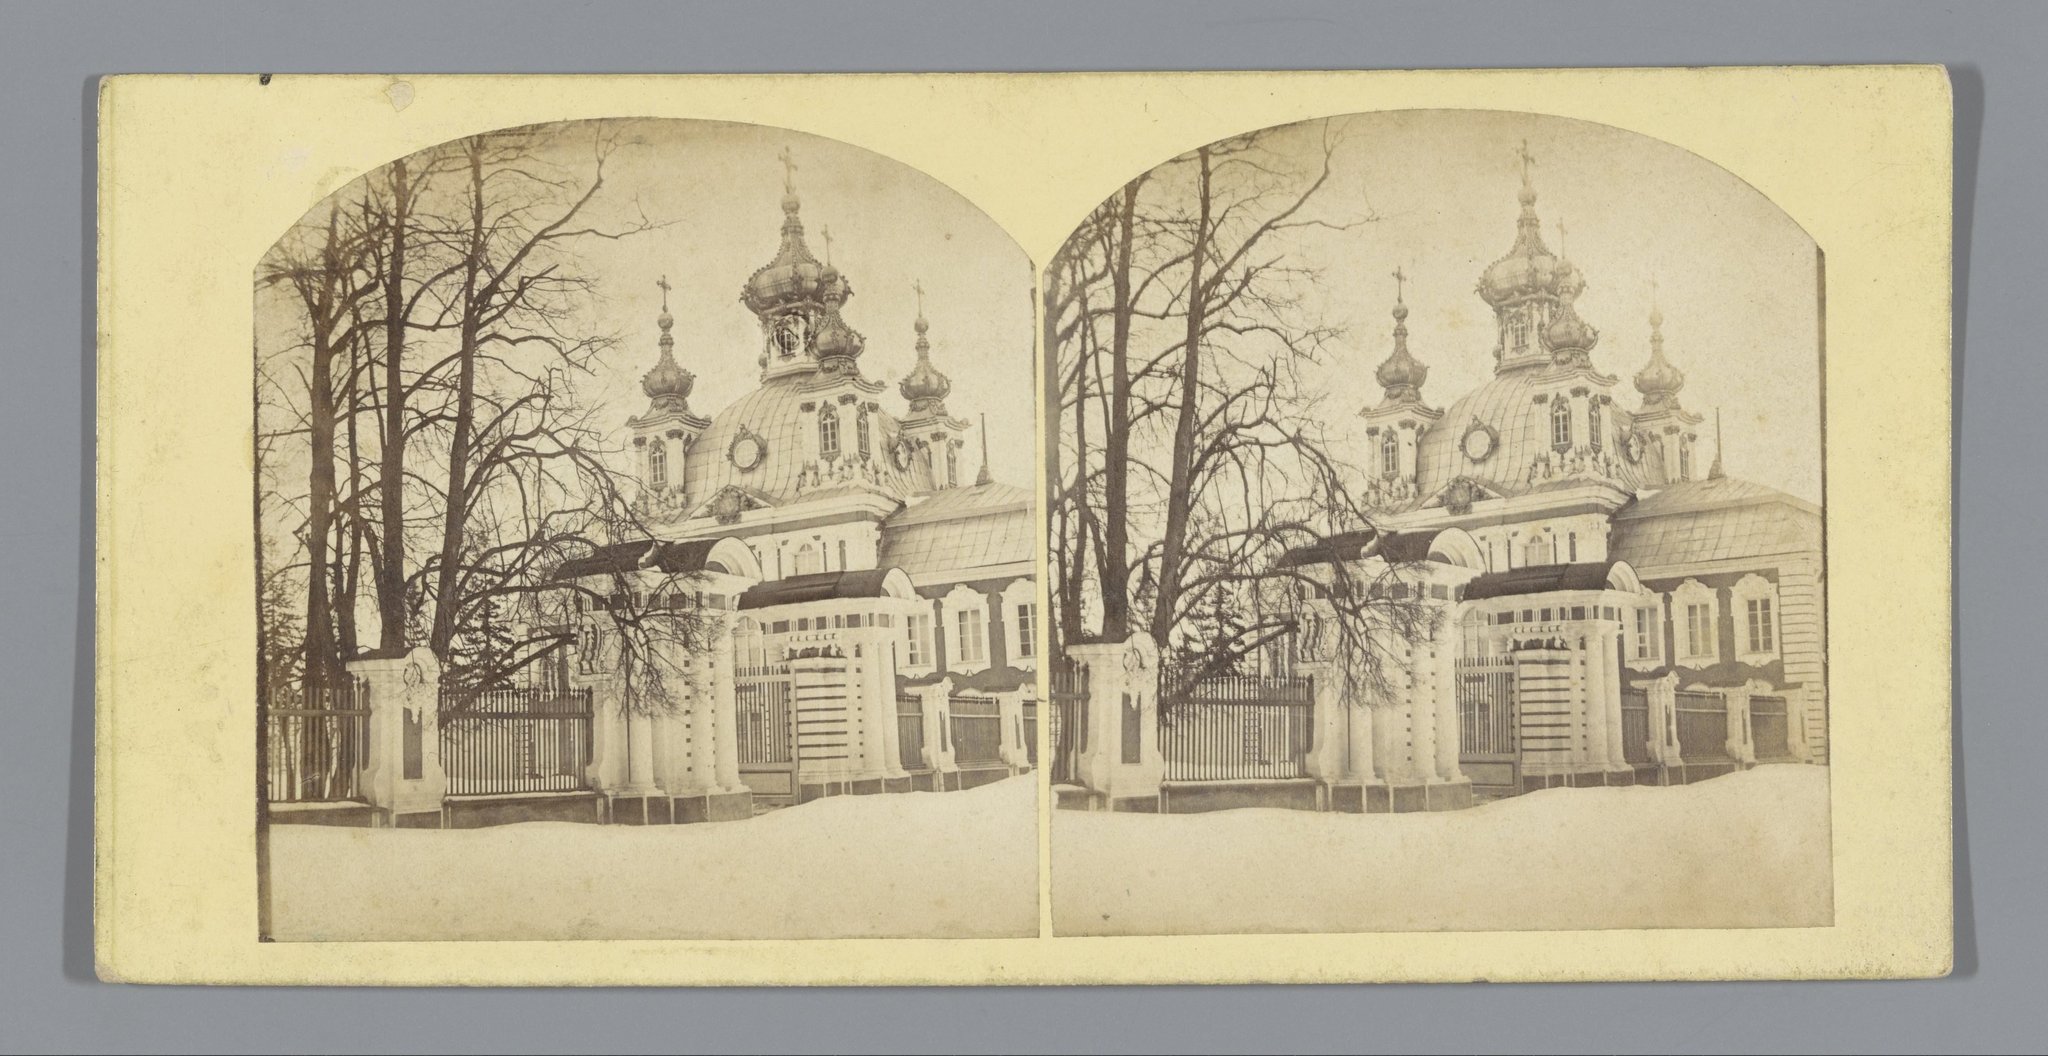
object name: stereograph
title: Gezicht op een Paleis van Peterhof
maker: Anonymous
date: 1850-1880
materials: cardboard, photographic support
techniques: albumen print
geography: peterhof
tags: palace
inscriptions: inscription: ‘St. Pétersbourg Palais de Peterhoff.’